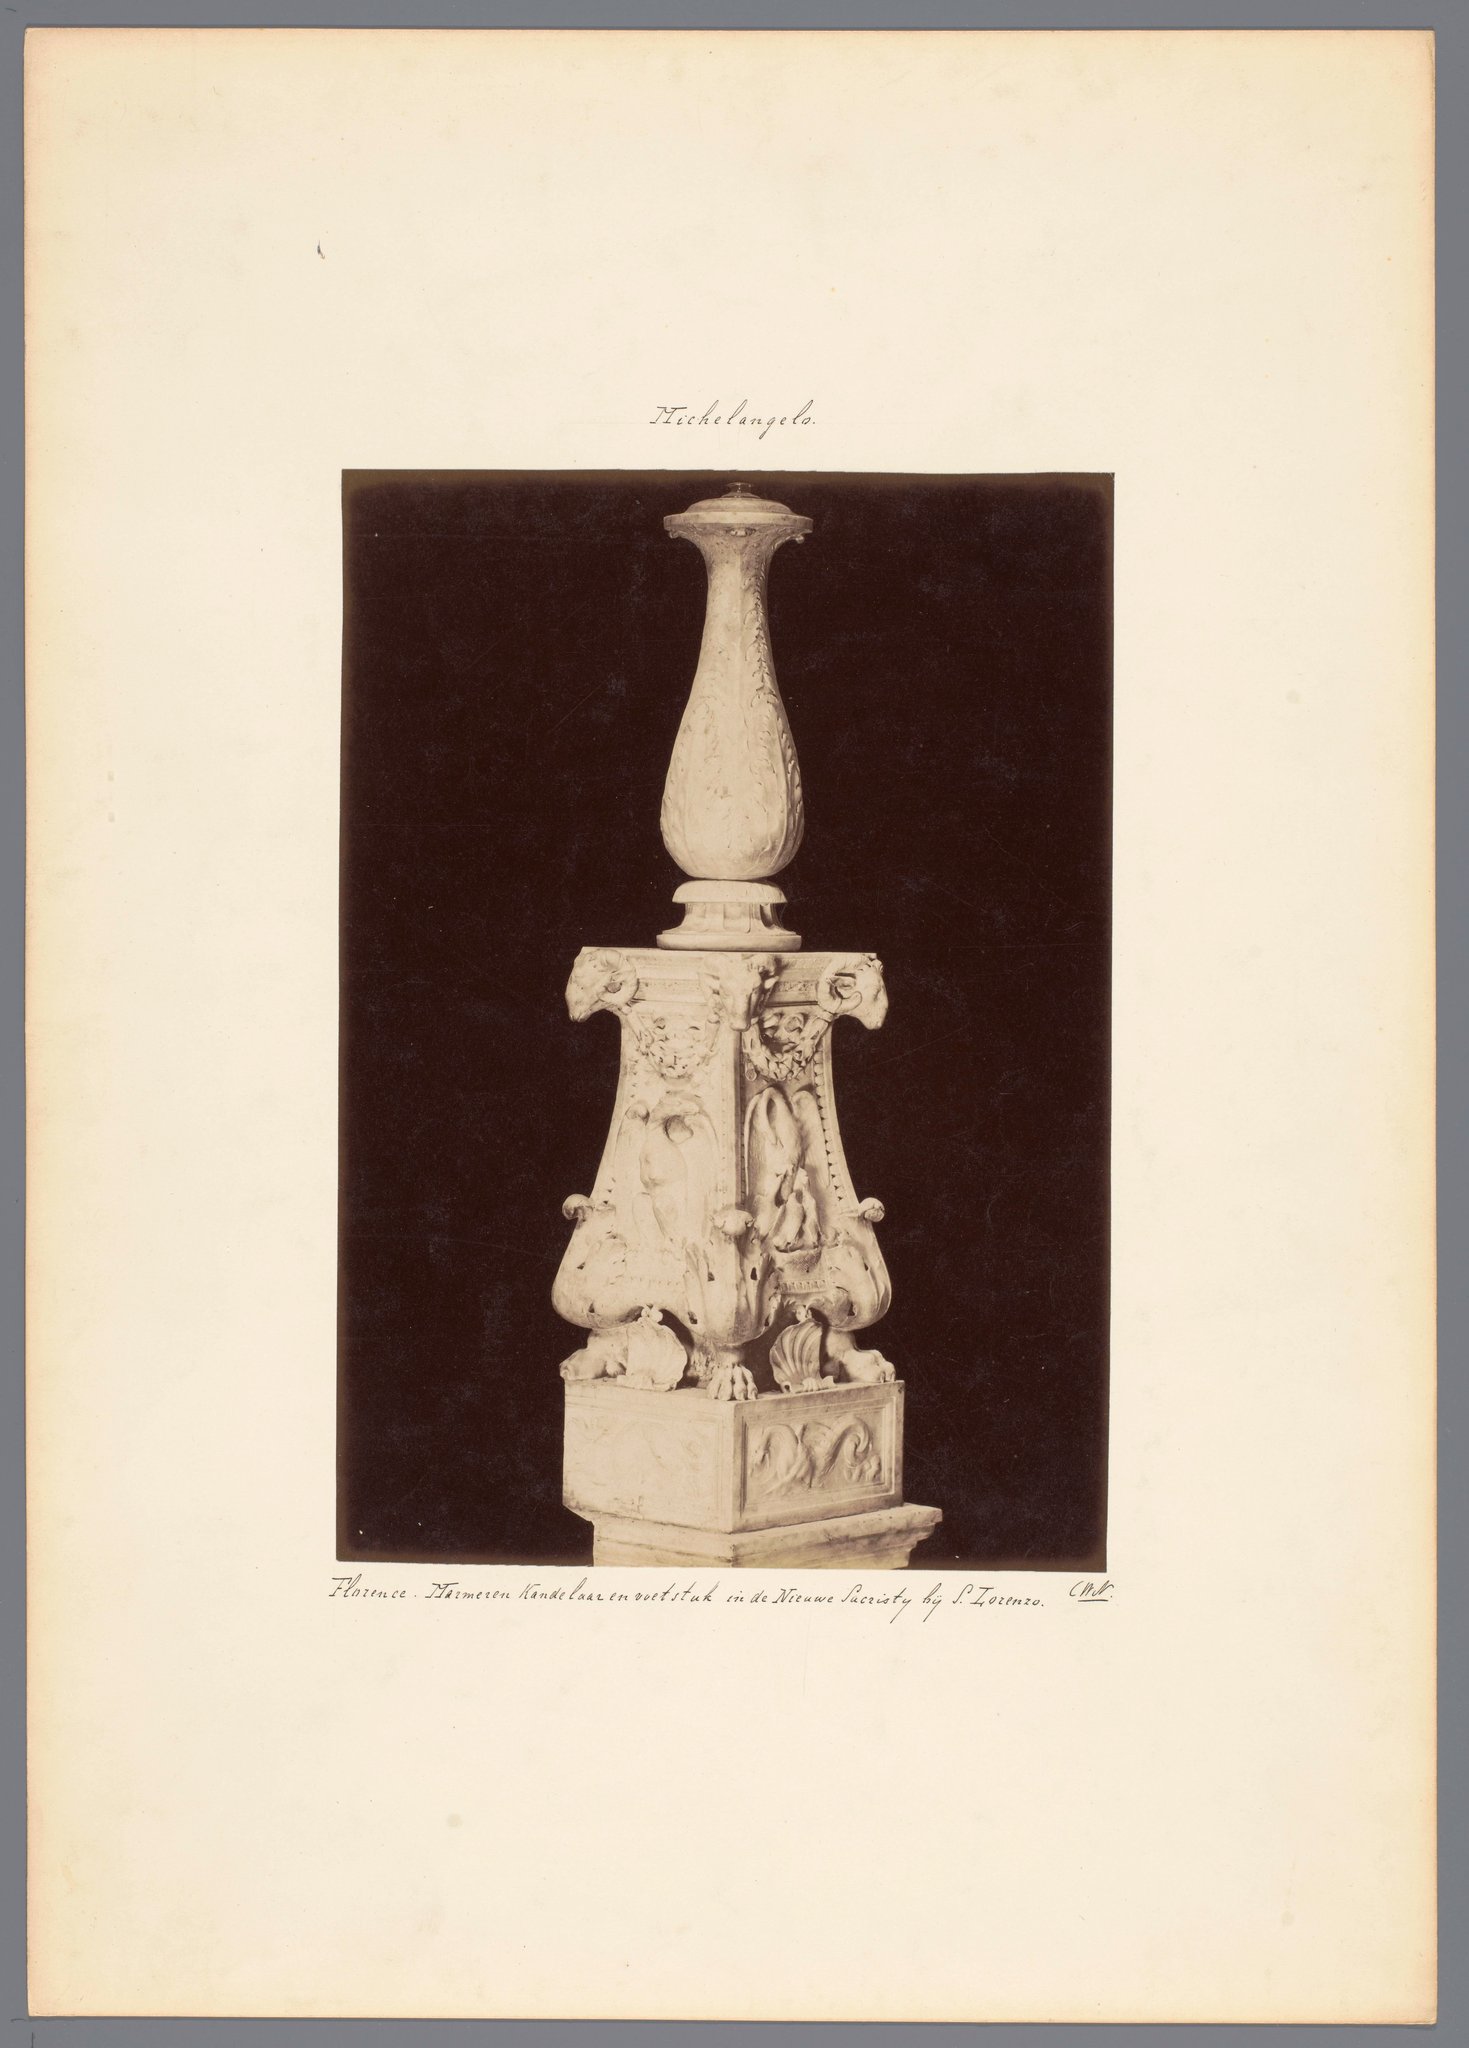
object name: photograph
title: Michelangelo. Florence. Marmeren Kandelaar en voetstuk in de Nieuwe Sacristy bij S. Lorenzo.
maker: Anonymous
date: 1875-1900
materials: cardboard, photographic support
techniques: albumen print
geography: sint-laurensbasiliek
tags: ram's head ~ ornament, candlestick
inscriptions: collector's mark: ‘INSTITUUT VOOR KUNST-NIJVERHEIDSONDERWIJS GABRIËL METSUSTRAAT No. 16 AMSTERDAM’, inscription: ‘CWN.’, collector's mark: ‘KUNSTNIJVERHEIDSCHOOL QUELLINUS AMSTERDAM FRANS HALSSTRAAT 14.’